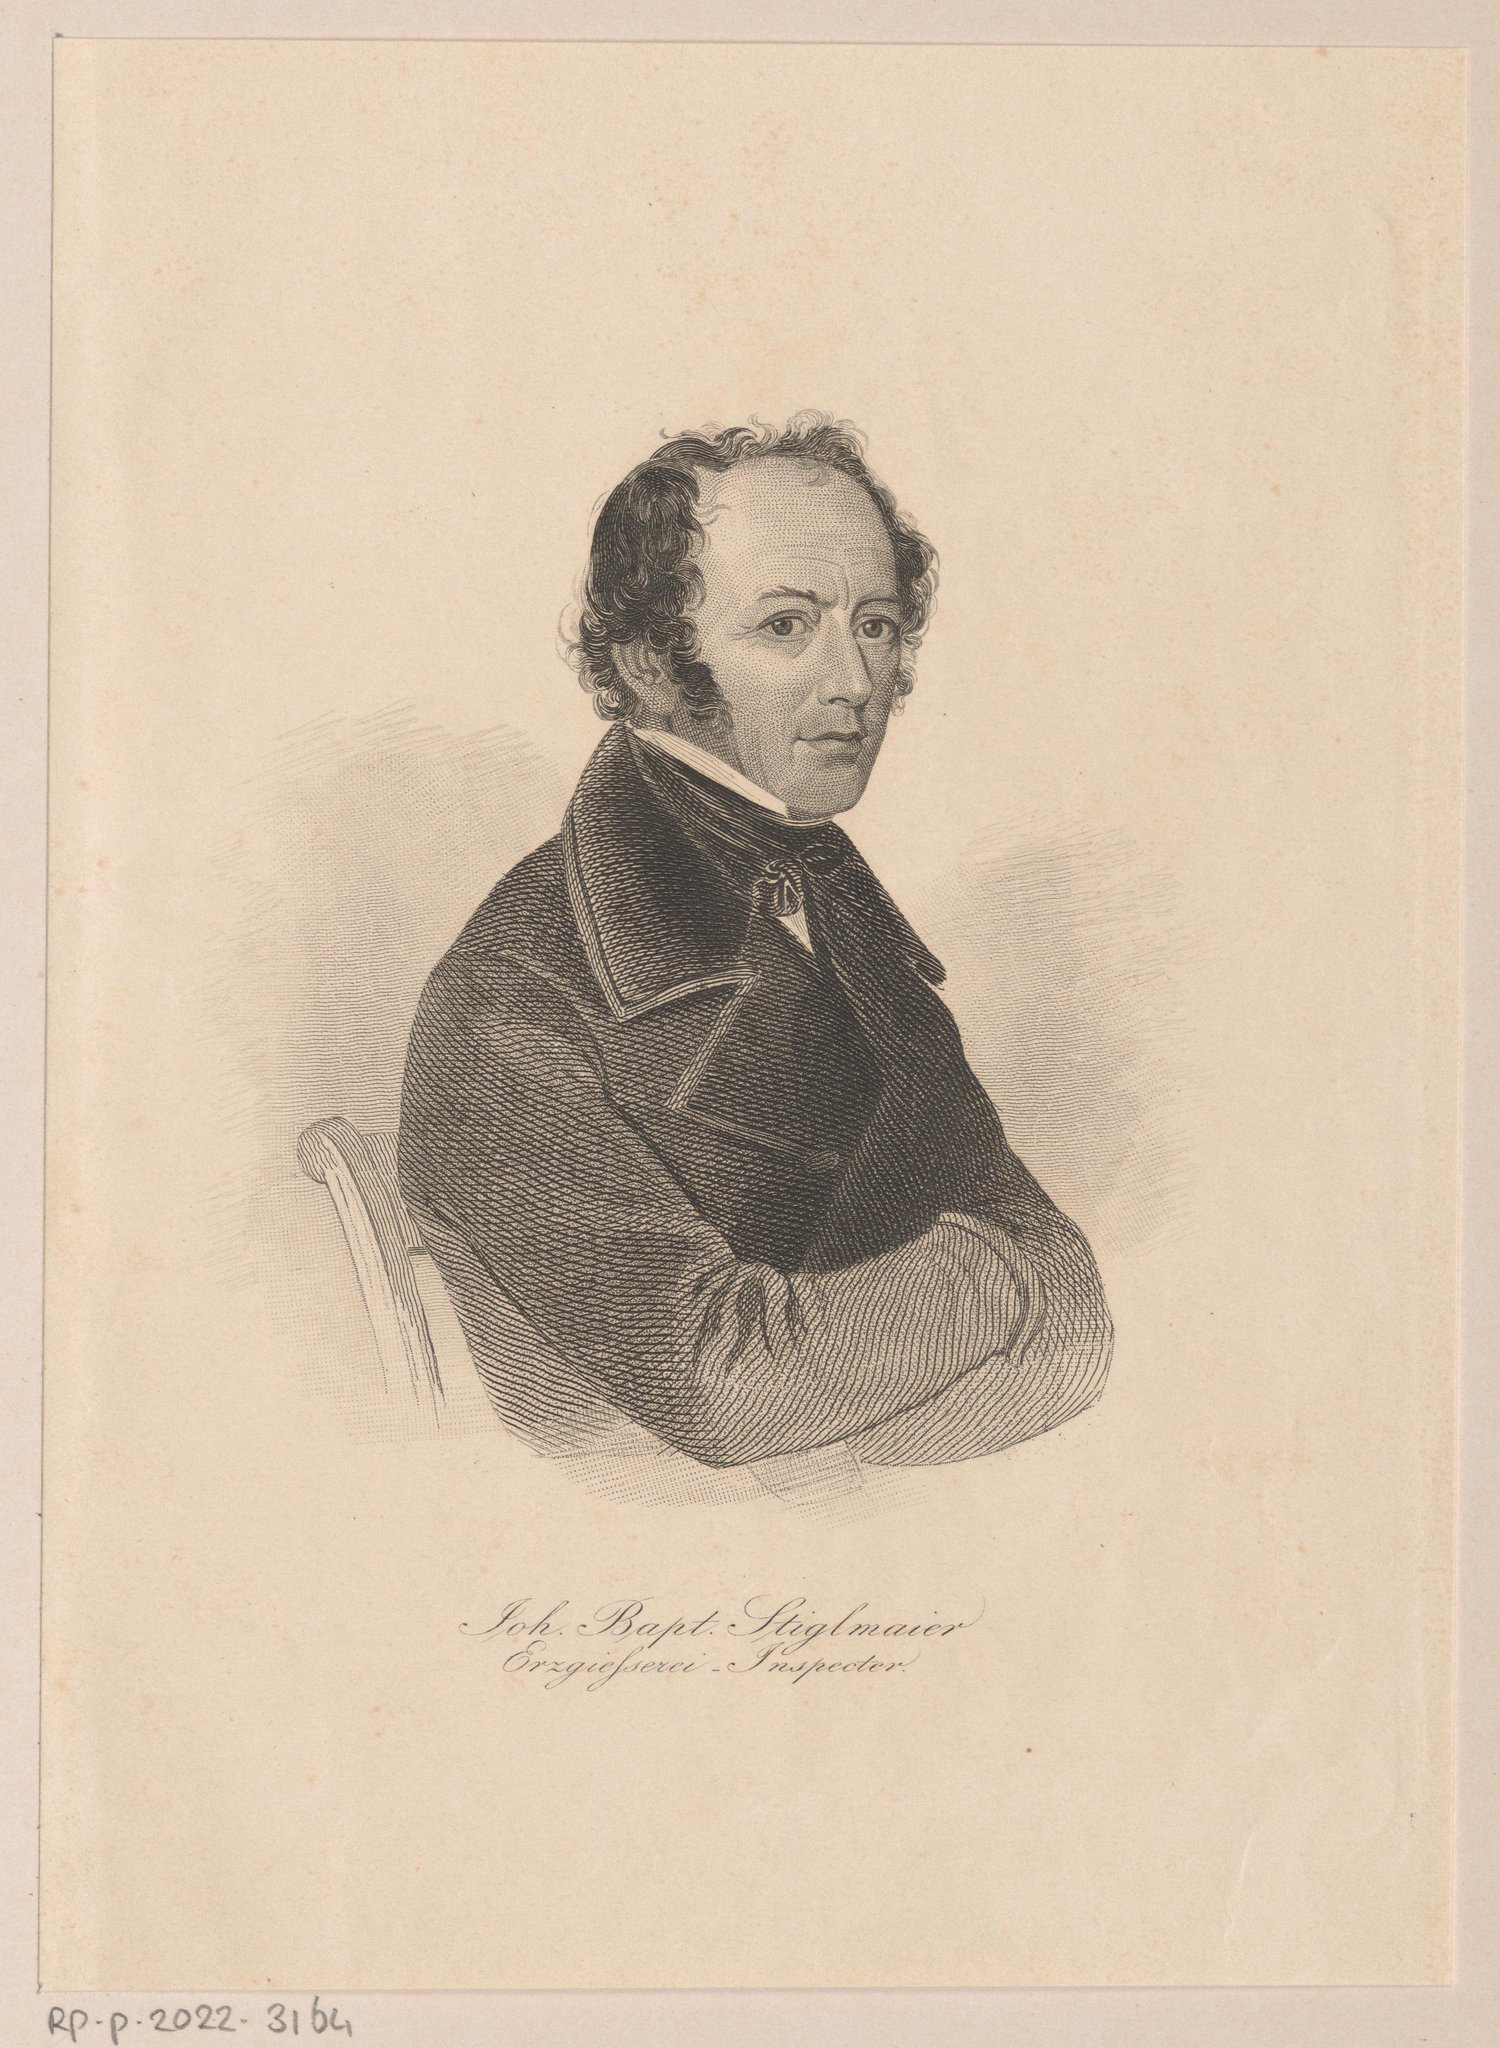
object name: print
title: Portret van Johann Baptist Stiglmaier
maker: Anonymous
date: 1825-1899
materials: paper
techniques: engraving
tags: sculptor, johann baptist stiglmaier, portrait, self-portrait of sculptor, historical persons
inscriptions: collector's mark: Lugt 2228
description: Met eenregelig onderschrift in het Duits.